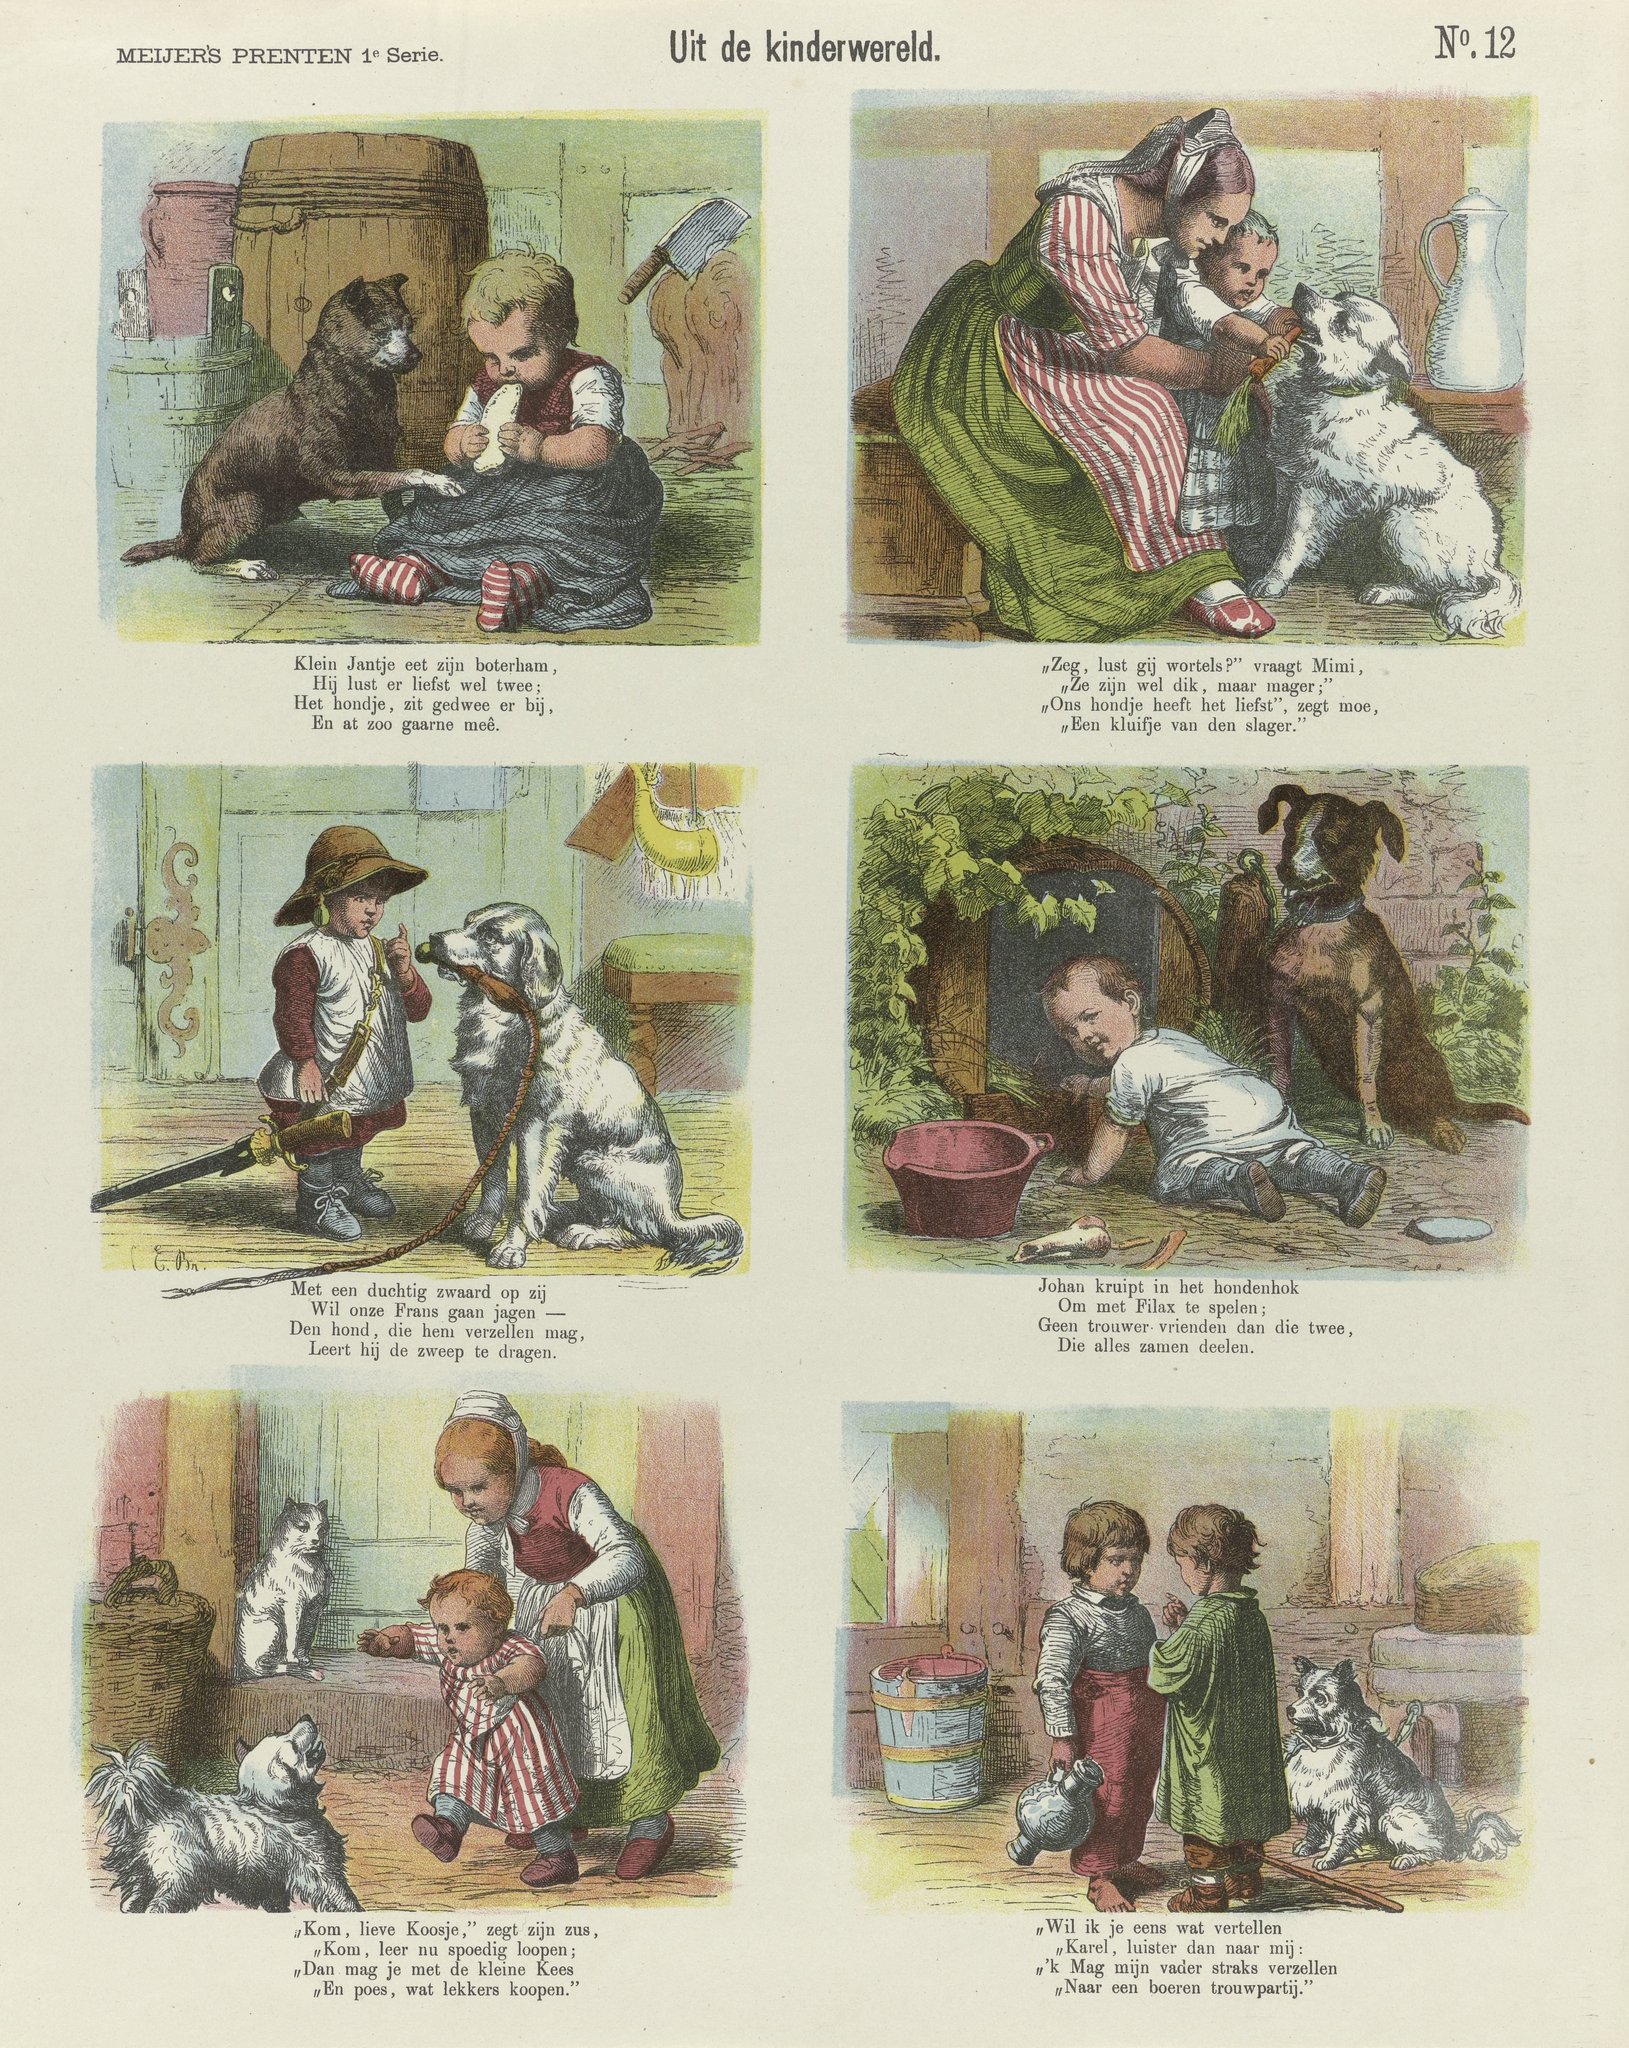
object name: popular print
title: Uit de kinderwereld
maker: Anonymous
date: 1873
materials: paper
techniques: lithograph, letterpress printing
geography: amsterdam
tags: child, child playing with animals, dog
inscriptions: collector's mark: Lugt 2760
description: Blad met 6 voorstellingen van kinderen met honden. Onder elke voorstelling een vierregelig vers. Genummerd rechtsboven: No. 12.